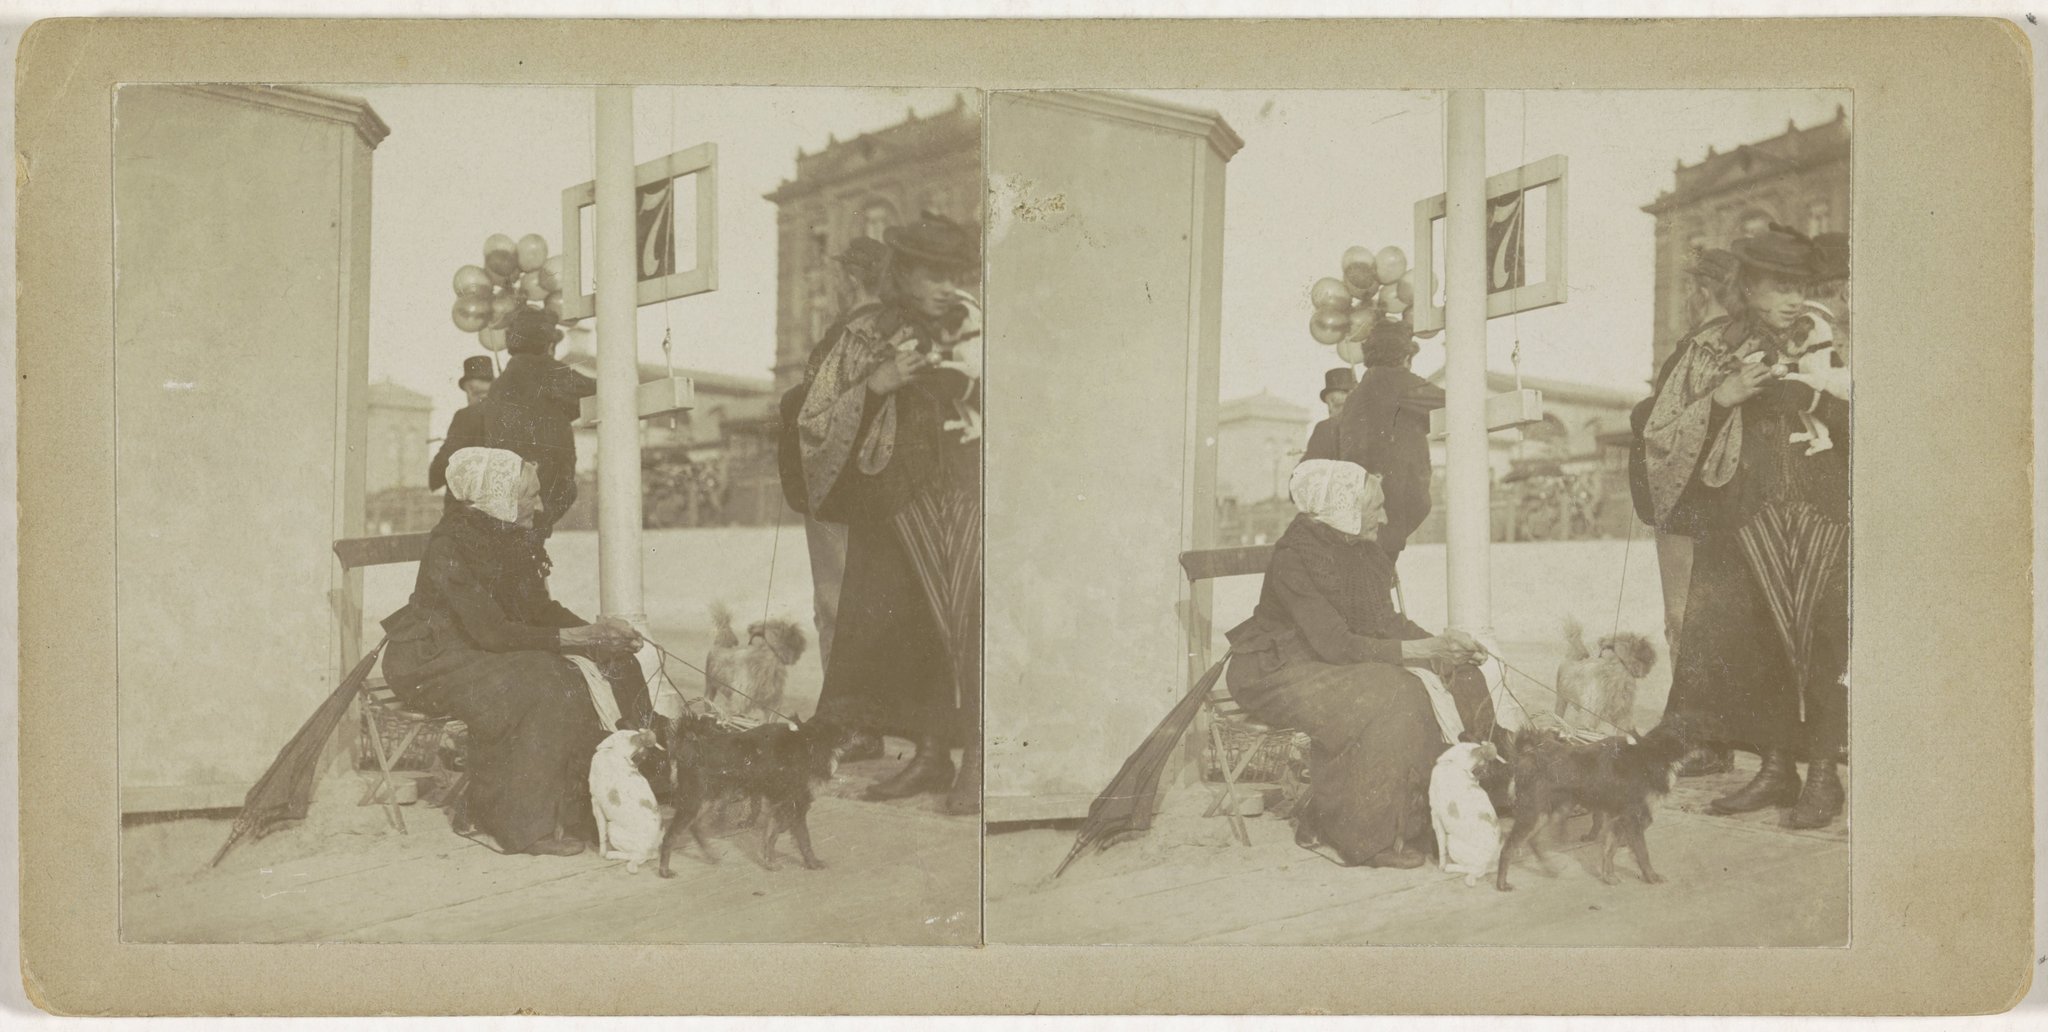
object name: stereograph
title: Hondenkoopvrouw, Scheveningen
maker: Anonymous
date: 1894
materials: cardboard, paper, photographic support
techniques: gelatin silver print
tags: scheveningen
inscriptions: annotation: ‘'s Gravenhage en omstreken: Hondenkoopvrouw te Scheveningen’, annotation: ‘Seizoen 1894.’